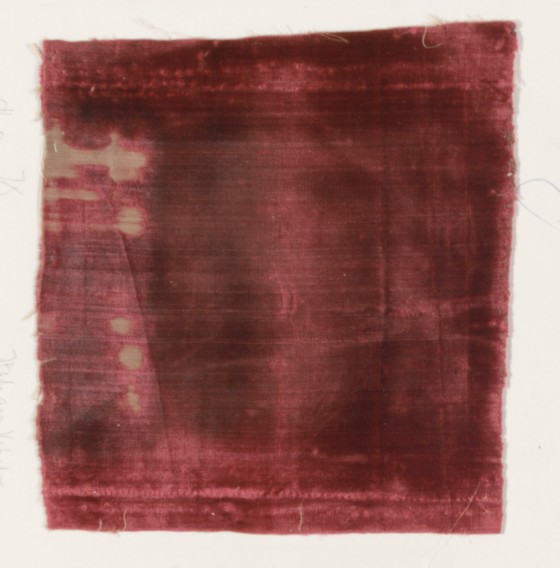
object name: fragment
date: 1501-1600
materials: silk